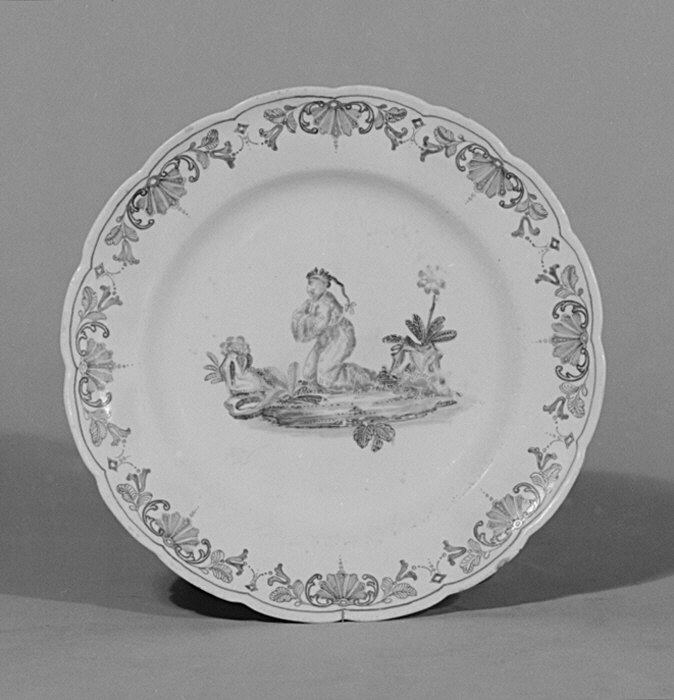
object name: plate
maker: vienna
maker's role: manufactory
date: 1730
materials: hard paste porcelain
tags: human figures,flowers